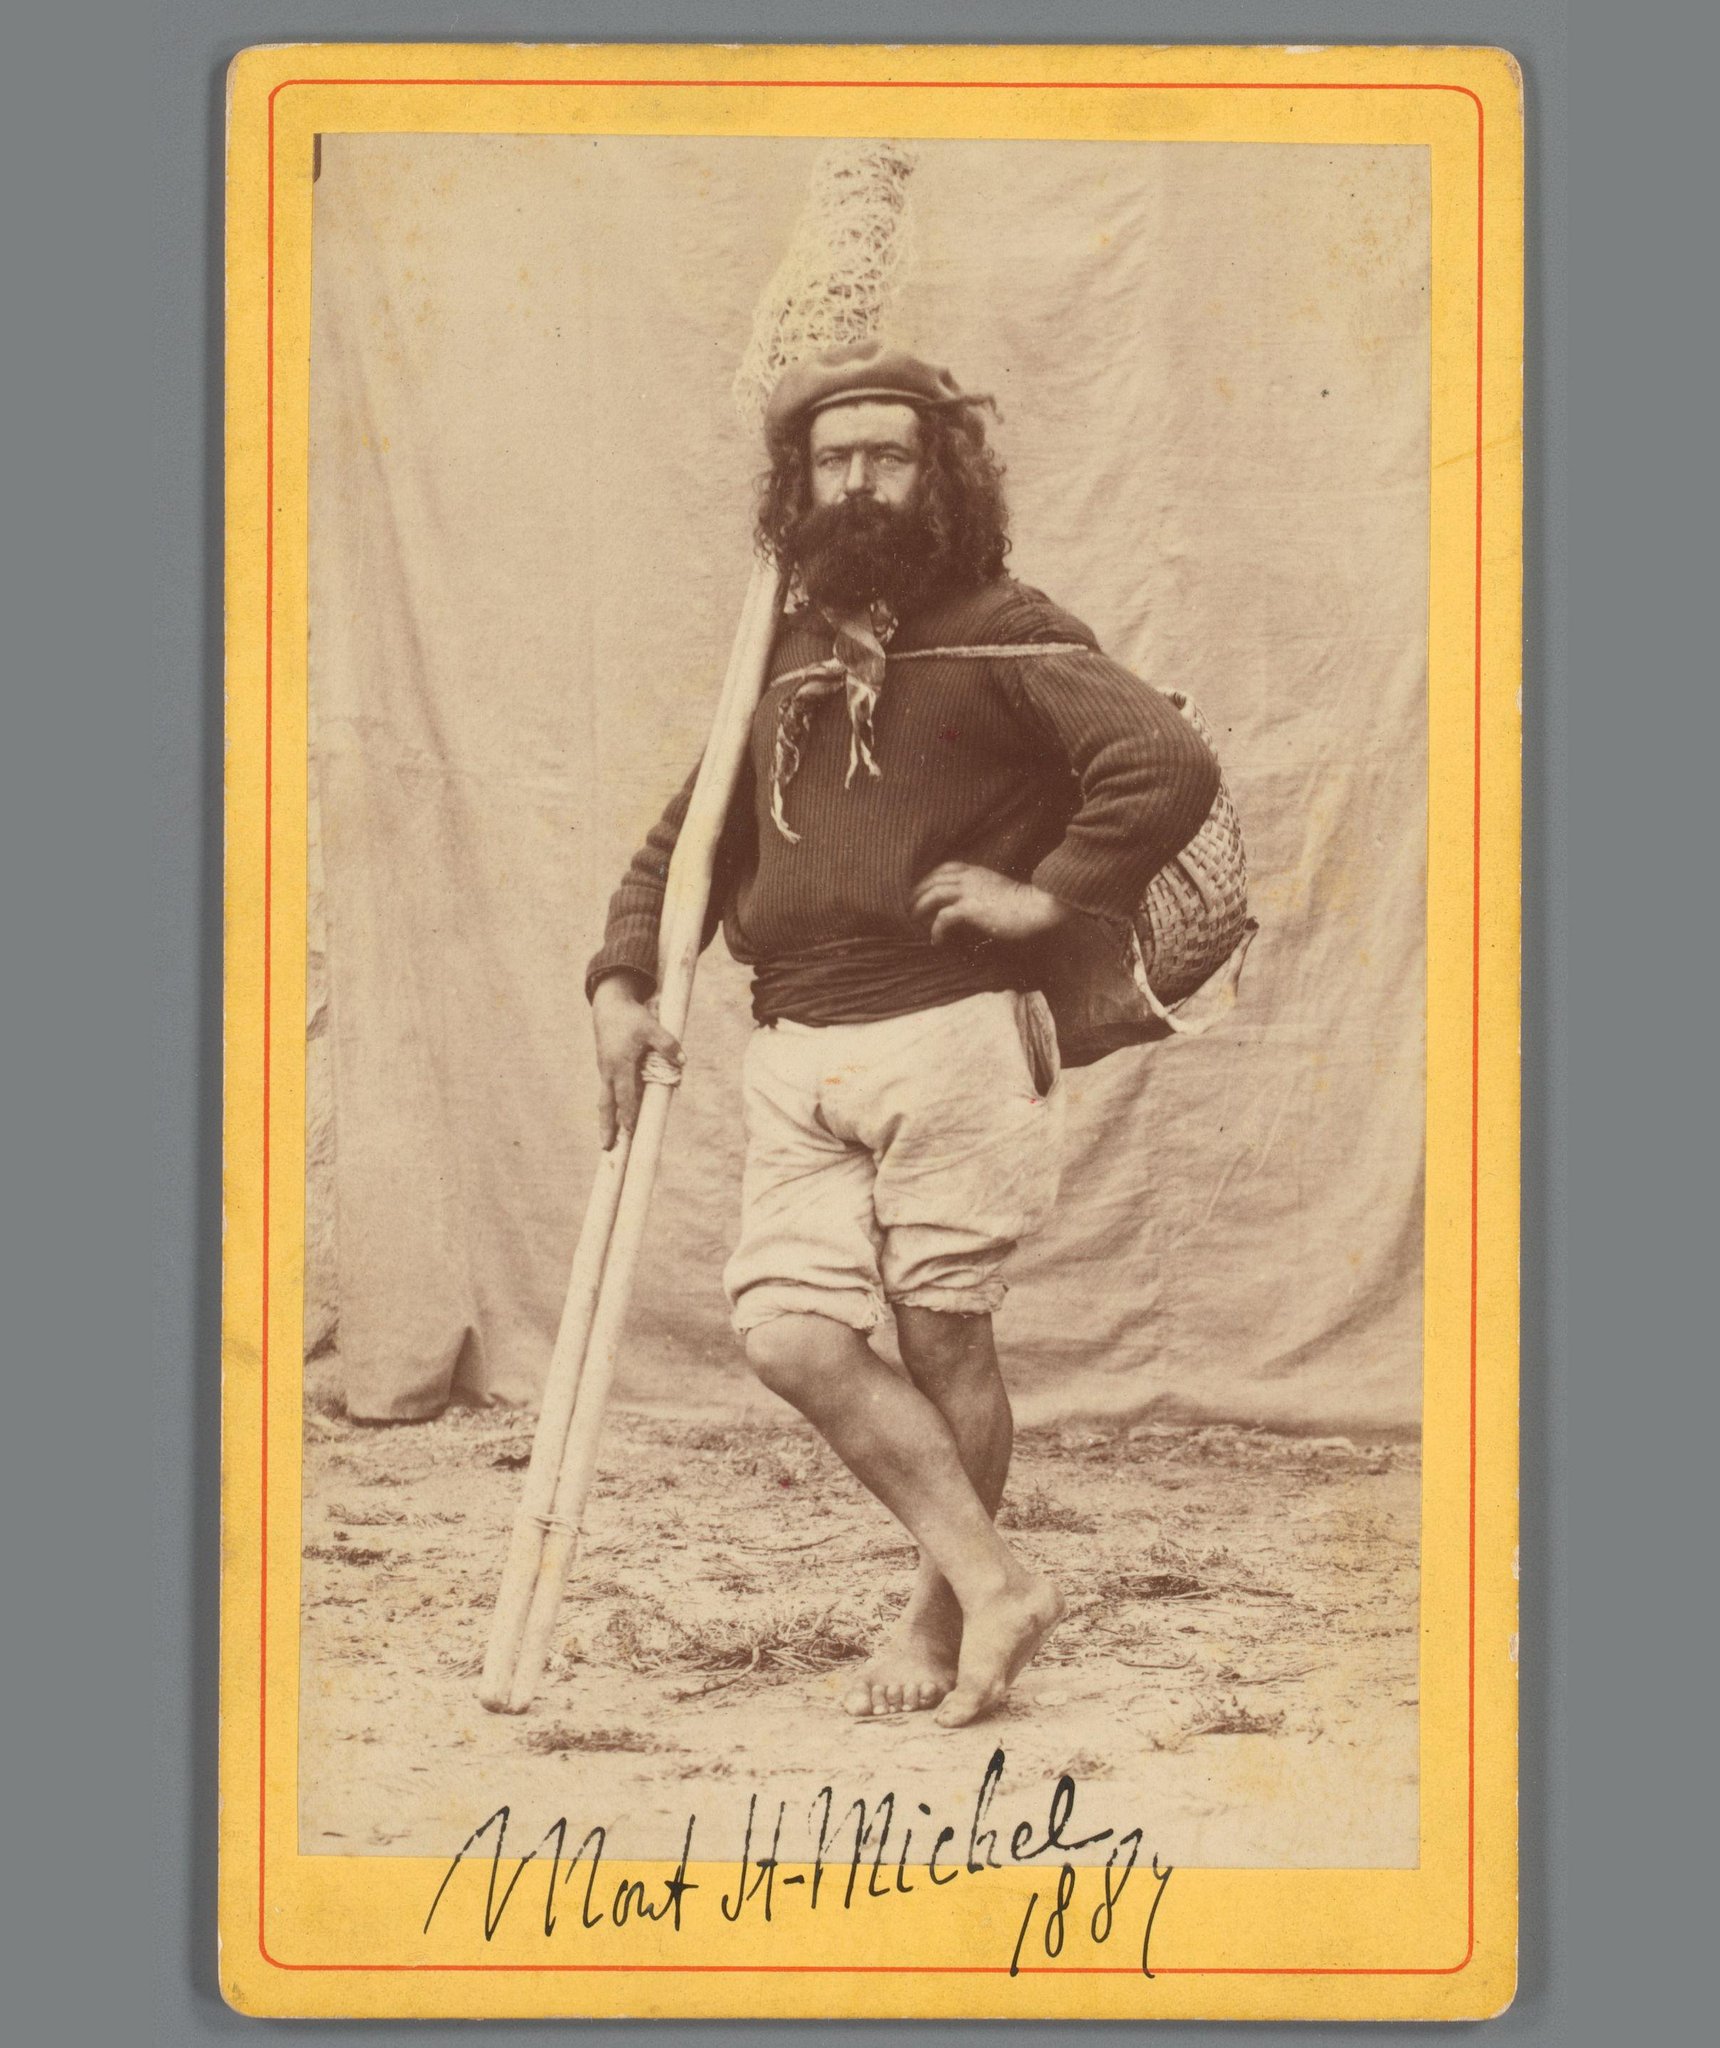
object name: cabinet photograph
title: Mont St-Michel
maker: Anonymous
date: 1887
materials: cardboard, paper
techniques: albumen print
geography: le mont-saint-michel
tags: anonymous historical person portrayed, fisherman